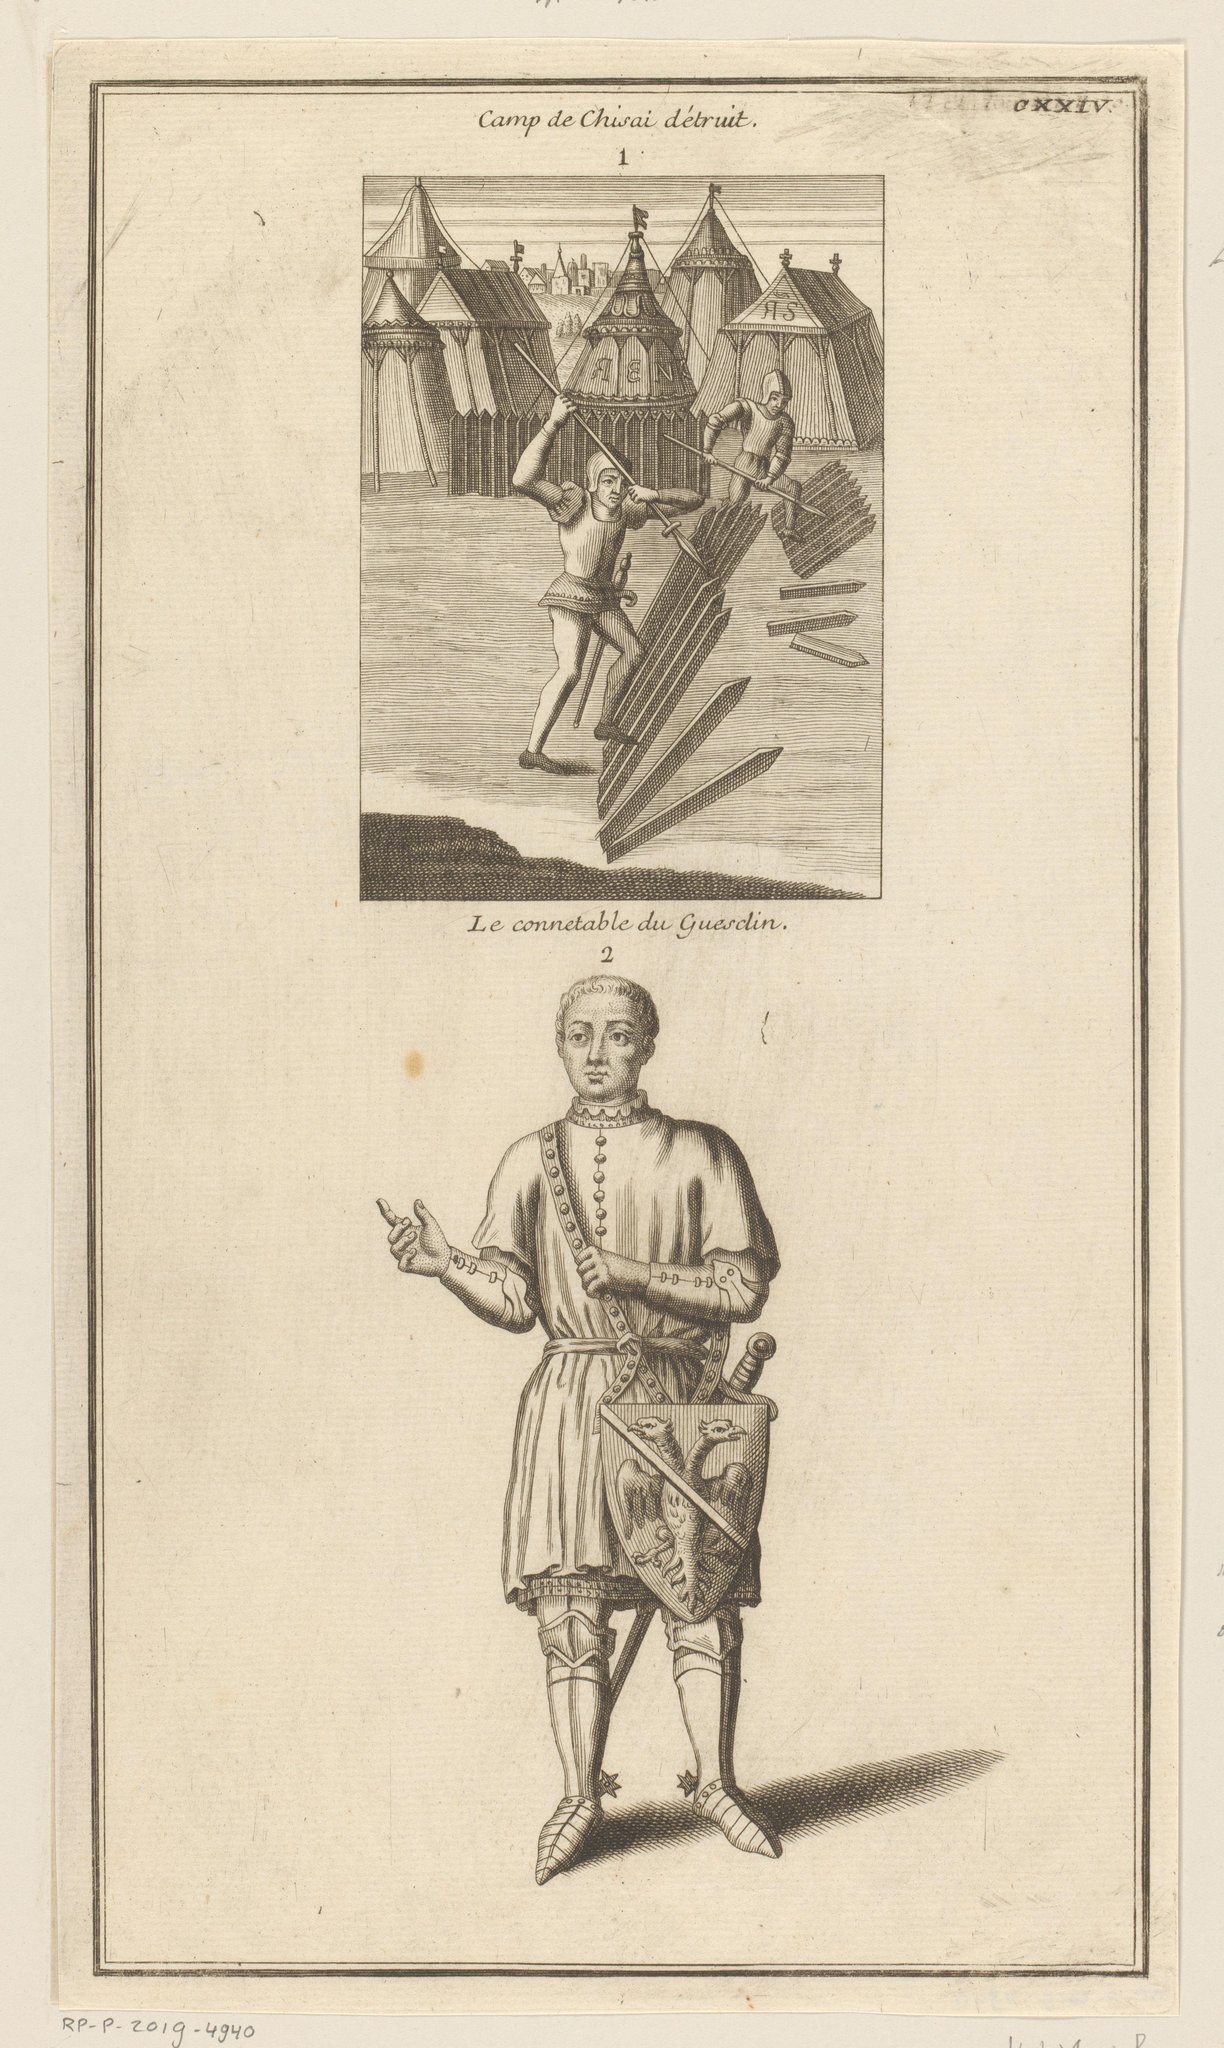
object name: book illustration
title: Portret van Bertrand du Guesclin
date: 1750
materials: paper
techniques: engraving, etching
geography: london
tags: (military) camp with tents, historical persons, armorial bearing, heraldry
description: Prent uit: Montfaucon, Bernard de. A collection of regal and ecclesiastical antiquities of France (...). Londen: William Innys, John en Paul Knapton, R. Manby en Henry Shute Cox, 1750, dl. 1. Prent voor het eerst, met andere nummering, verschenen in: Montfaucon, Bernard de. Les monumens de la Monarchie Françoise (...). Parijs: Julien-Michel Gandouin en Pierre-François Giffart, 1729-1733.